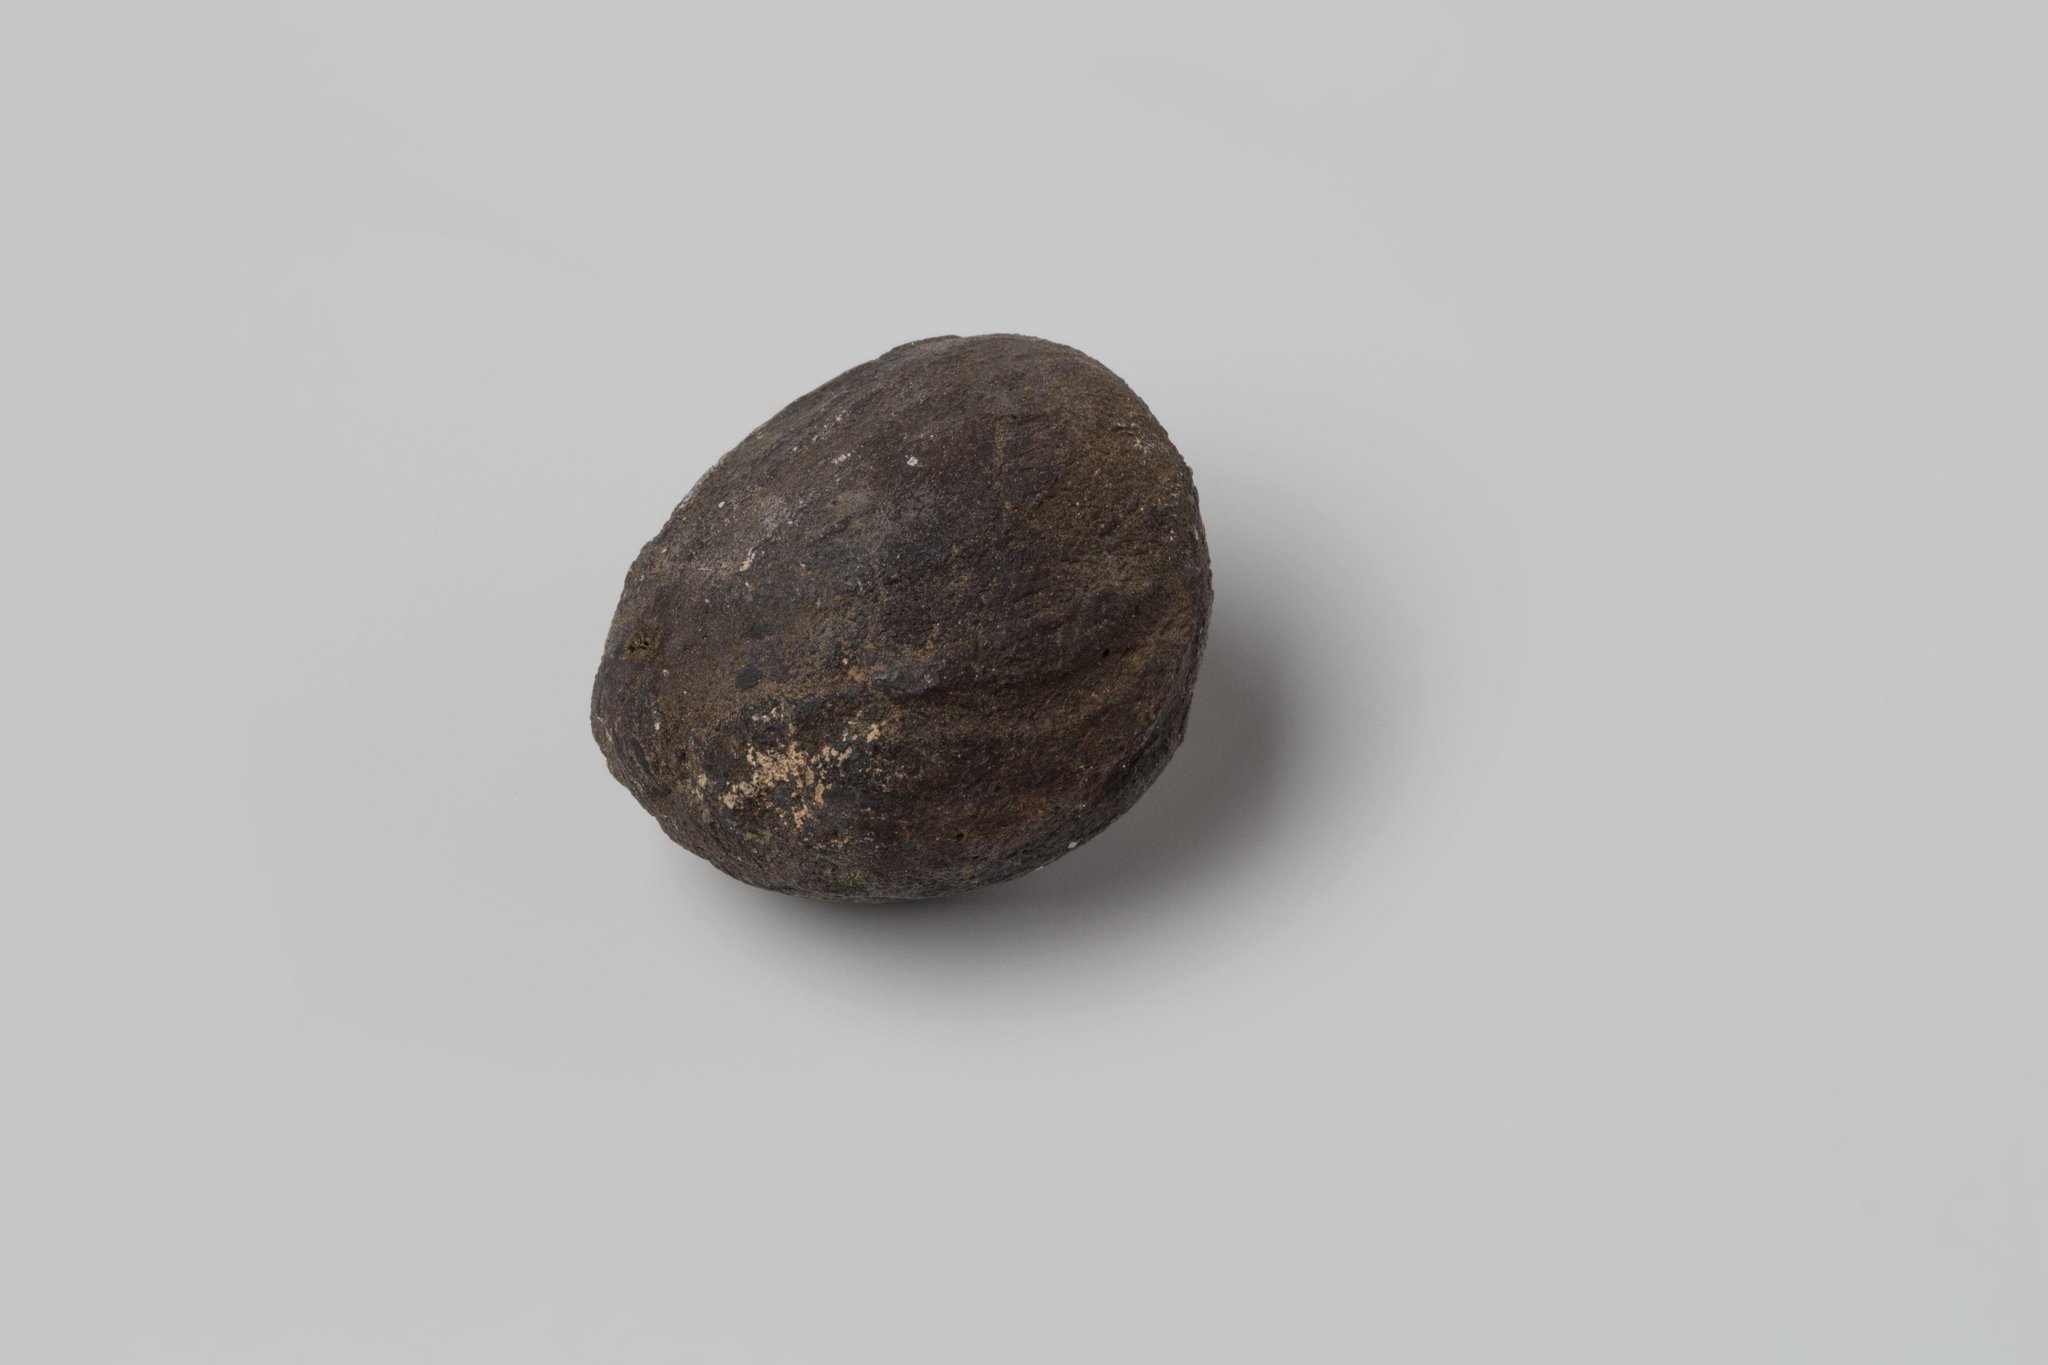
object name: nut plant material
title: Kemirinoot uit V.O.C.-schip de 'Witte Leeuw'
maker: Anonymous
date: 1613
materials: nut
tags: verenigde oostindische compagnie, sint-helena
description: Kemirinoot uit V.O.C.-schip de 'Witte Leeuw'.